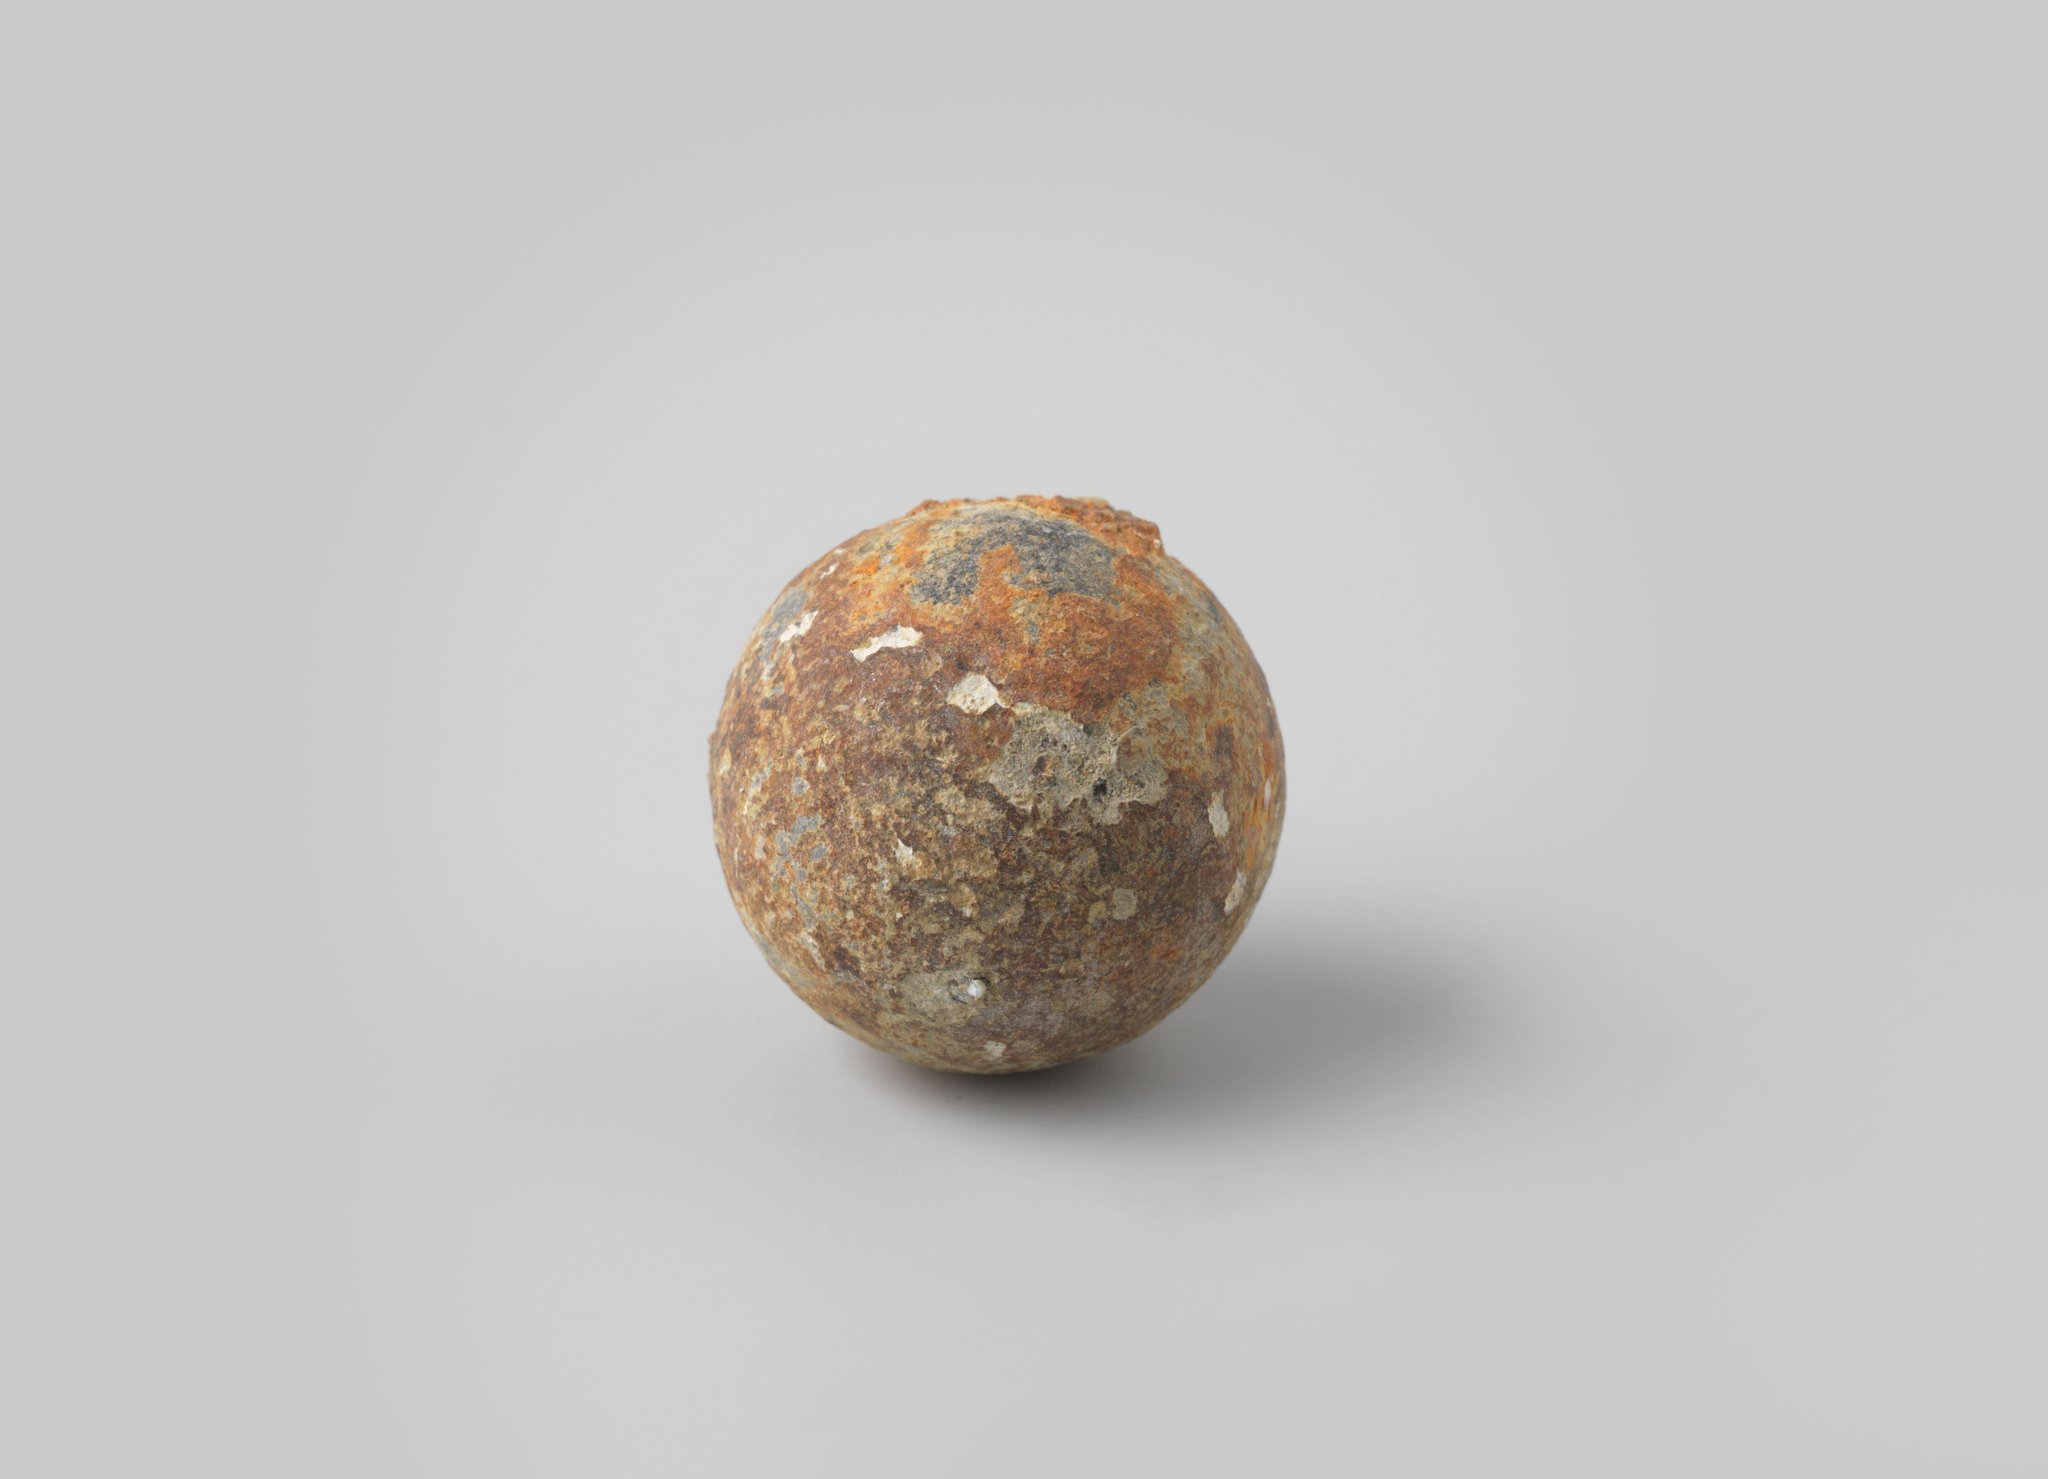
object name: musketkogel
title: Musketkogel uit het wrak van de Oost-Indiëvaarder Hollandia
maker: Anonymous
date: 1700-1743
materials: lead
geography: netherlands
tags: verenigde oostindische compagnie, hollandia (schip), annet